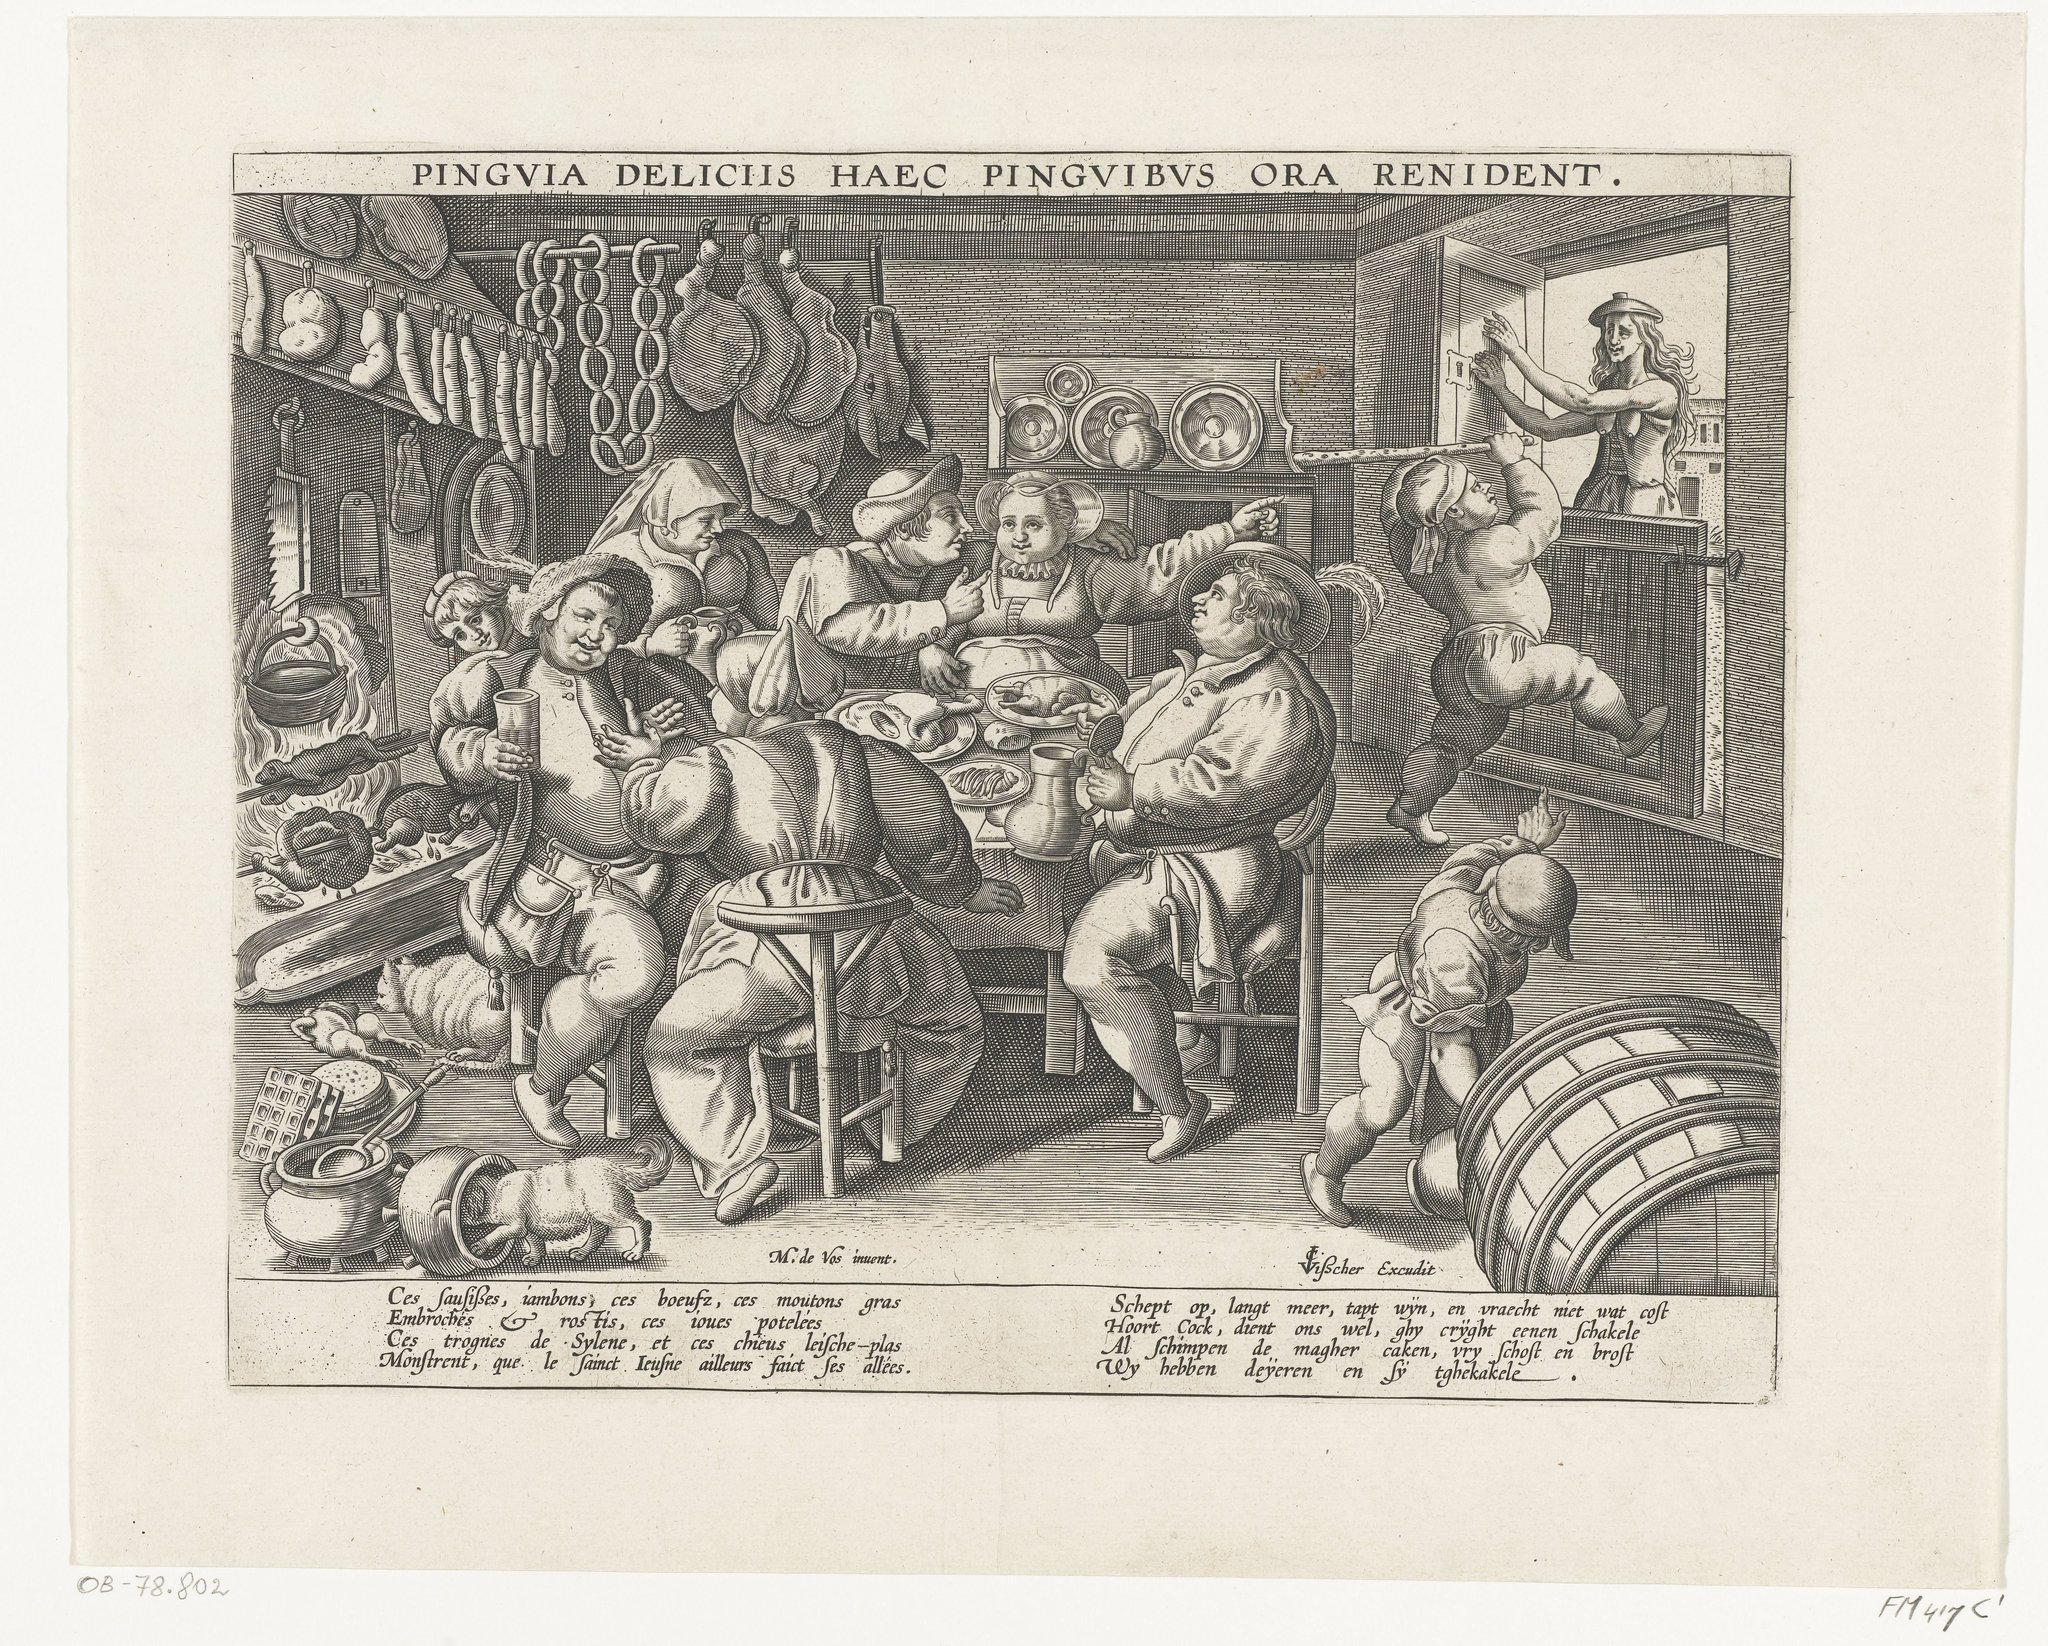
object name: print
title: De vette keuken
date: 1563-1599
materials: paper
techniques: engraving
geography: netherlands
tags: rich kitchen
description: De vette keuken. Interieur waarin een groep van dikke mensen aan een tafel zich aan allerlei eten en drinken te goed doet. Links wordt in de haard gekookt en gebraden. Op de achtergrond wordt een magere vrouw bij de deur met een stok verjaagd. Met onderschrift van vier regels in het Frans en vier regels in het Nederlands en een opschrift van een regel in het Latijn.